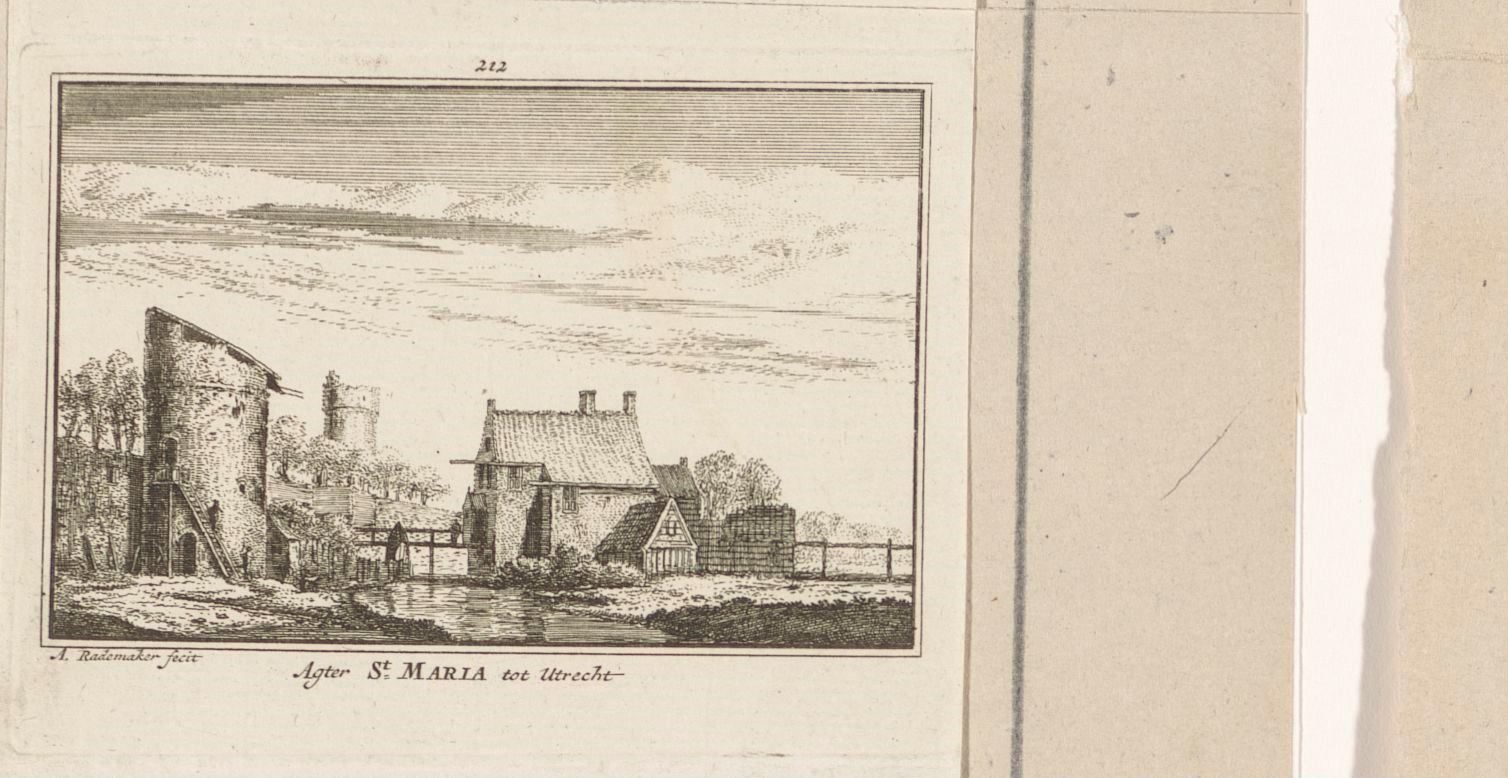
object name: print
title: Agter St. Maria tot Utrecht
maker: abraham rademaker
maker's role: draughtsman, print maker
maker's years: 1676-1735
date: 1725-1803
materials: paper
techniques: engraving, etching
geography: amsterdam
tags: urban housing, tower (of house or building)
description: Prent ook gebruikt in: Rademaker, Abraham. Kabinet van Nederlandsche outheden en gezichten: vervat in 300 konstplaaten (…). 2 delen. Amsterdam: Willem Barents, 1725, dl. 2, ill. 212. Na 1725 is deze prent nog in verschillende heruitgaven verschenen, uitgegeven in 1727-1733, 1770-1771 en 1792-1803. Uit welke uitgave het huidige exemplaar precies komt is niet na te gaan.